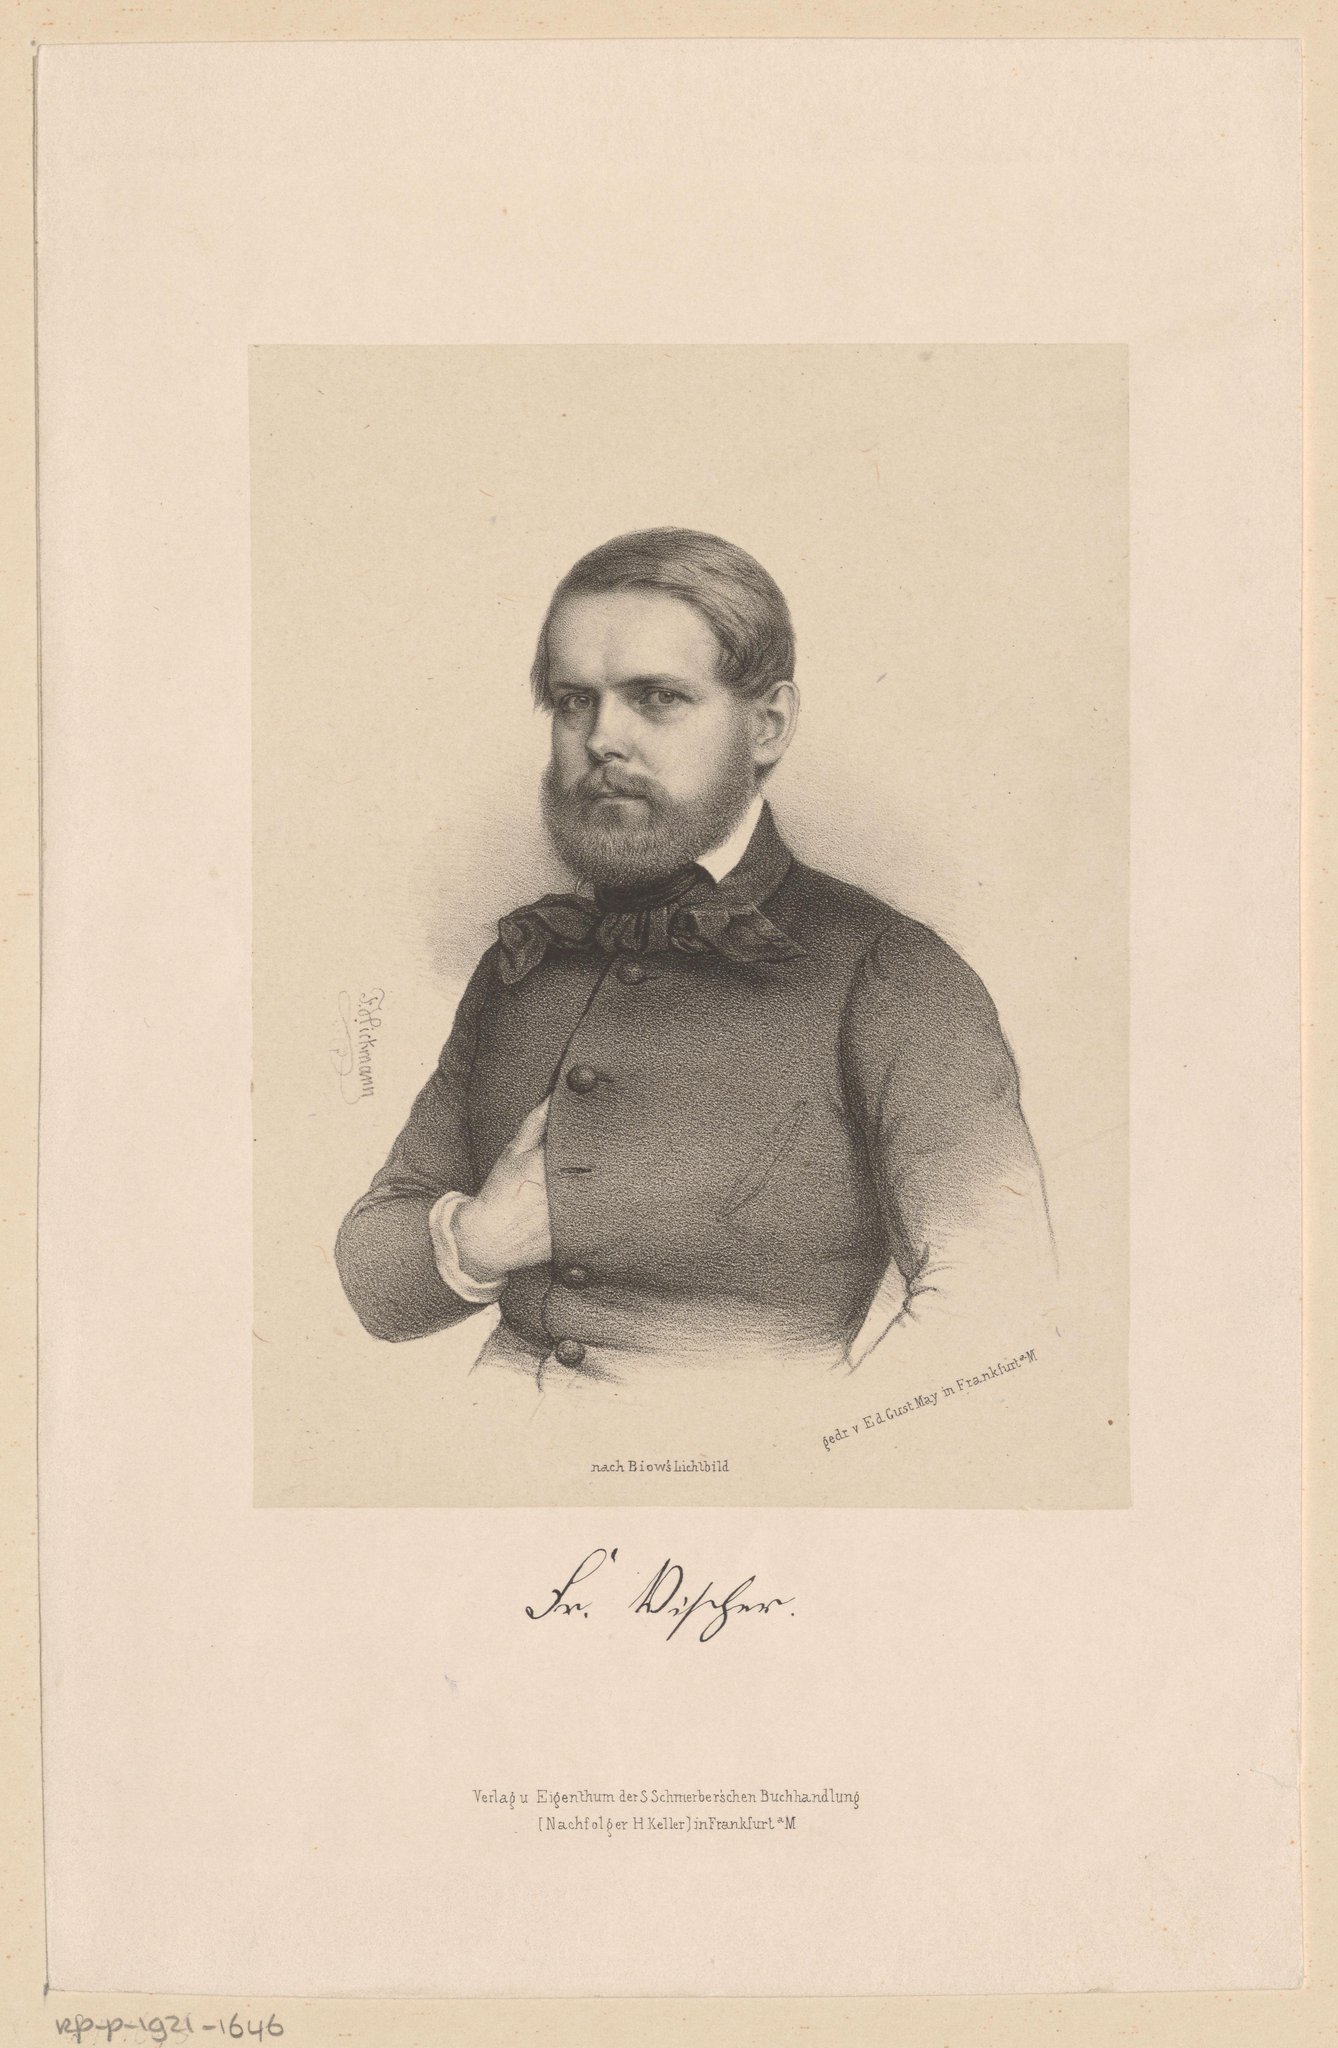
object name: print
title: Portret van Friedrich Theodor von Vischer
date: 1834-1884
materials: paper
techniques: lithograph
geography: frankfurt am main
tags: scholar, philosopher, historical persons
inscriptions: collector's mark: Lugt 2233